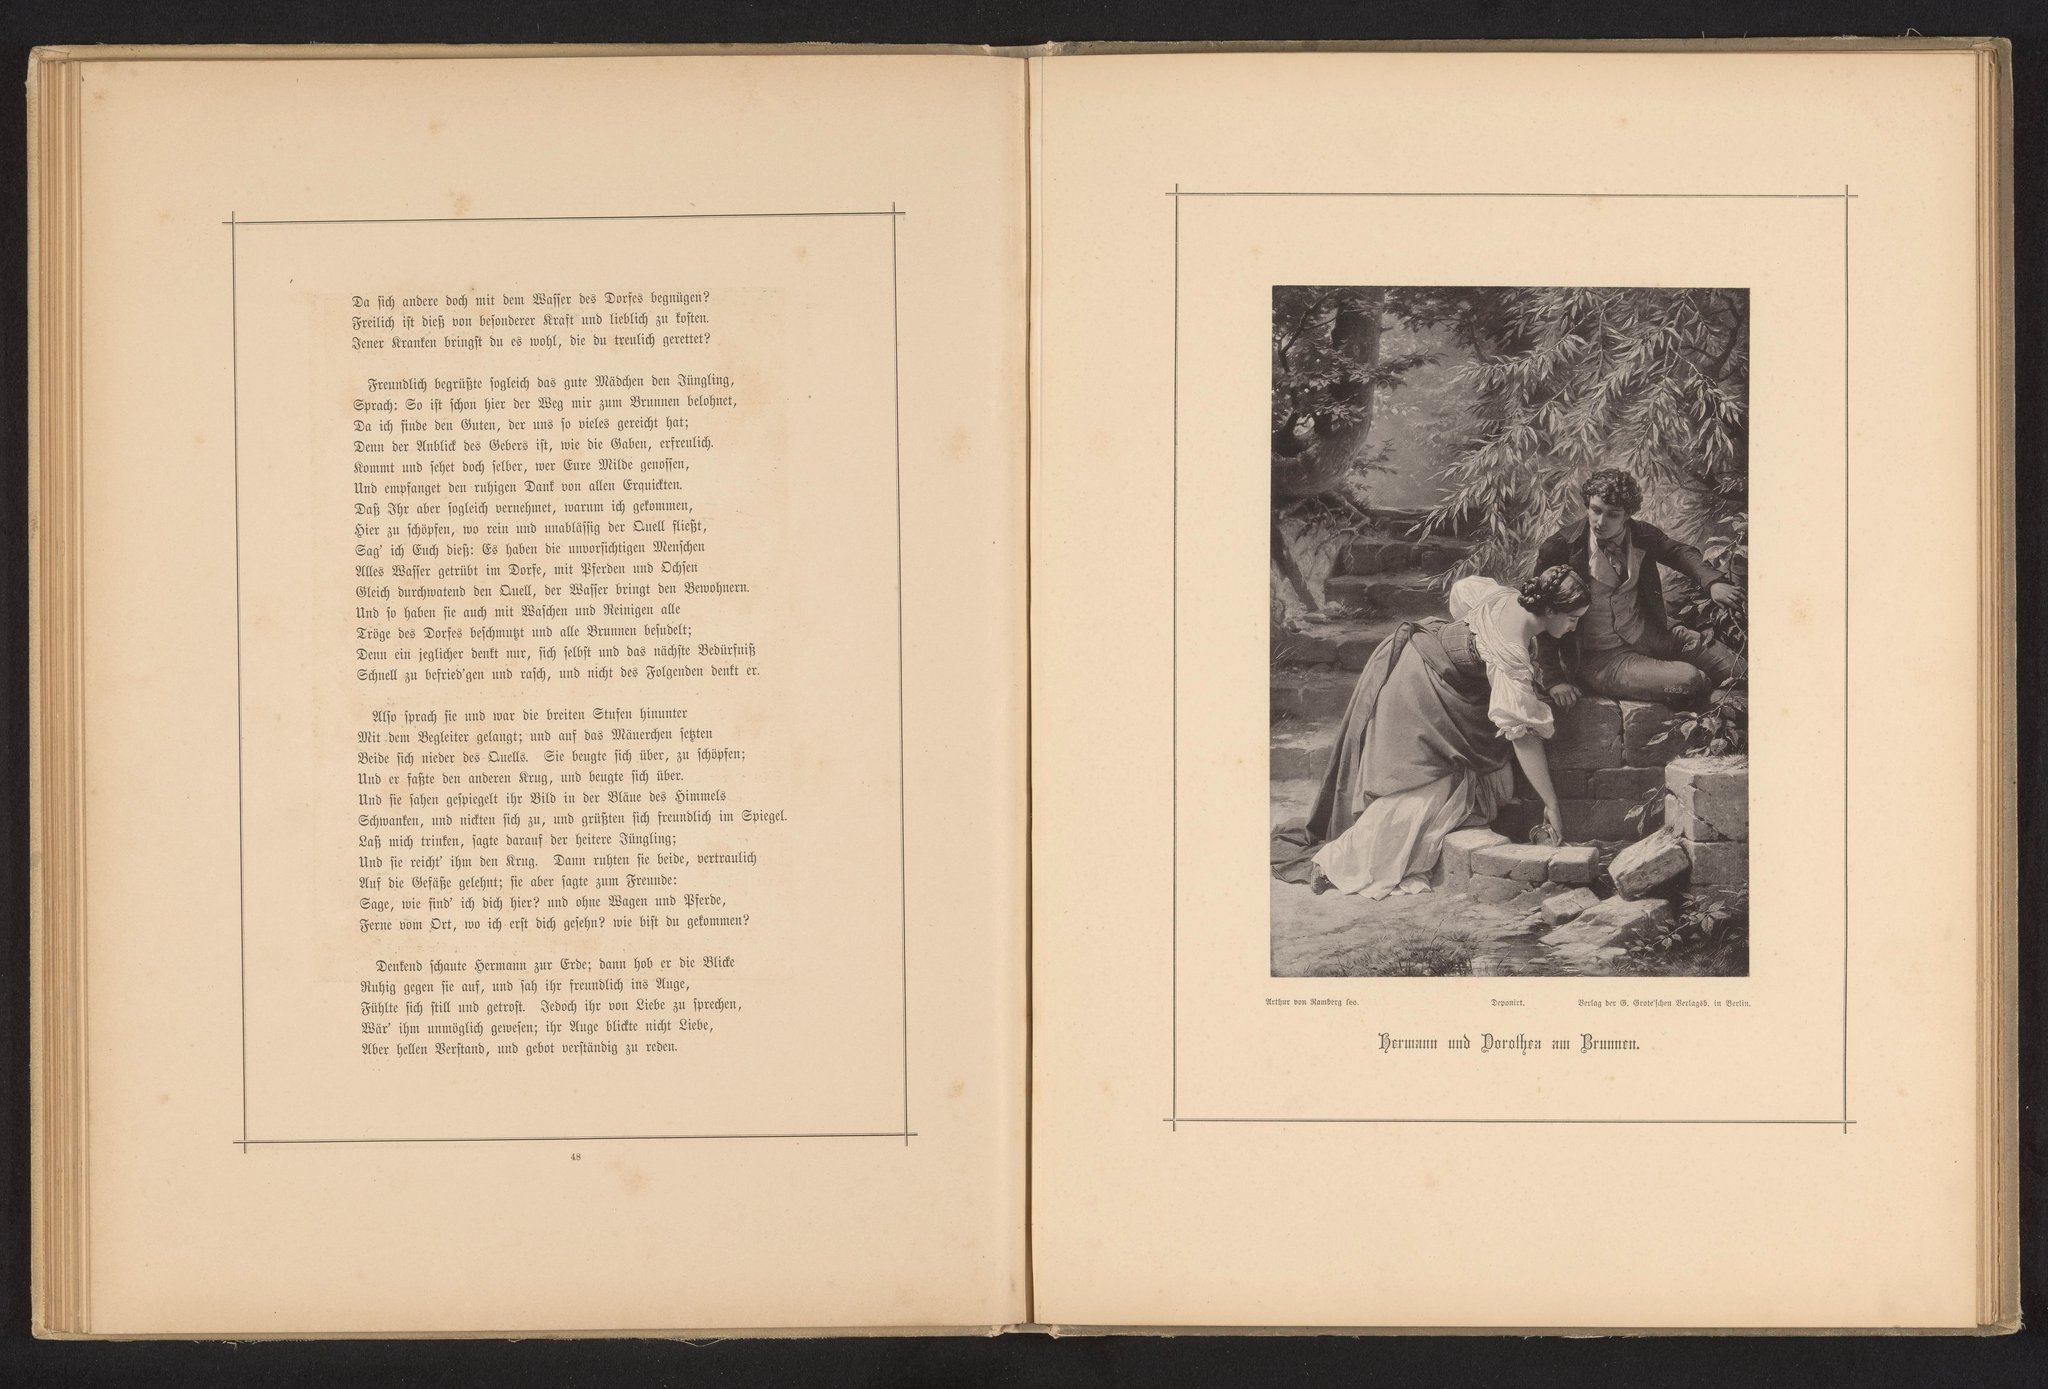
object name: photomechanical print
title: Fotoreproductie van een schilderij, voorstellende Hermann en Dorothea bij de waterput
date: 1876-1881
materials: paper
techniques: photograph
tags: well, adolescent, young woman, maiden, youth, adolescent